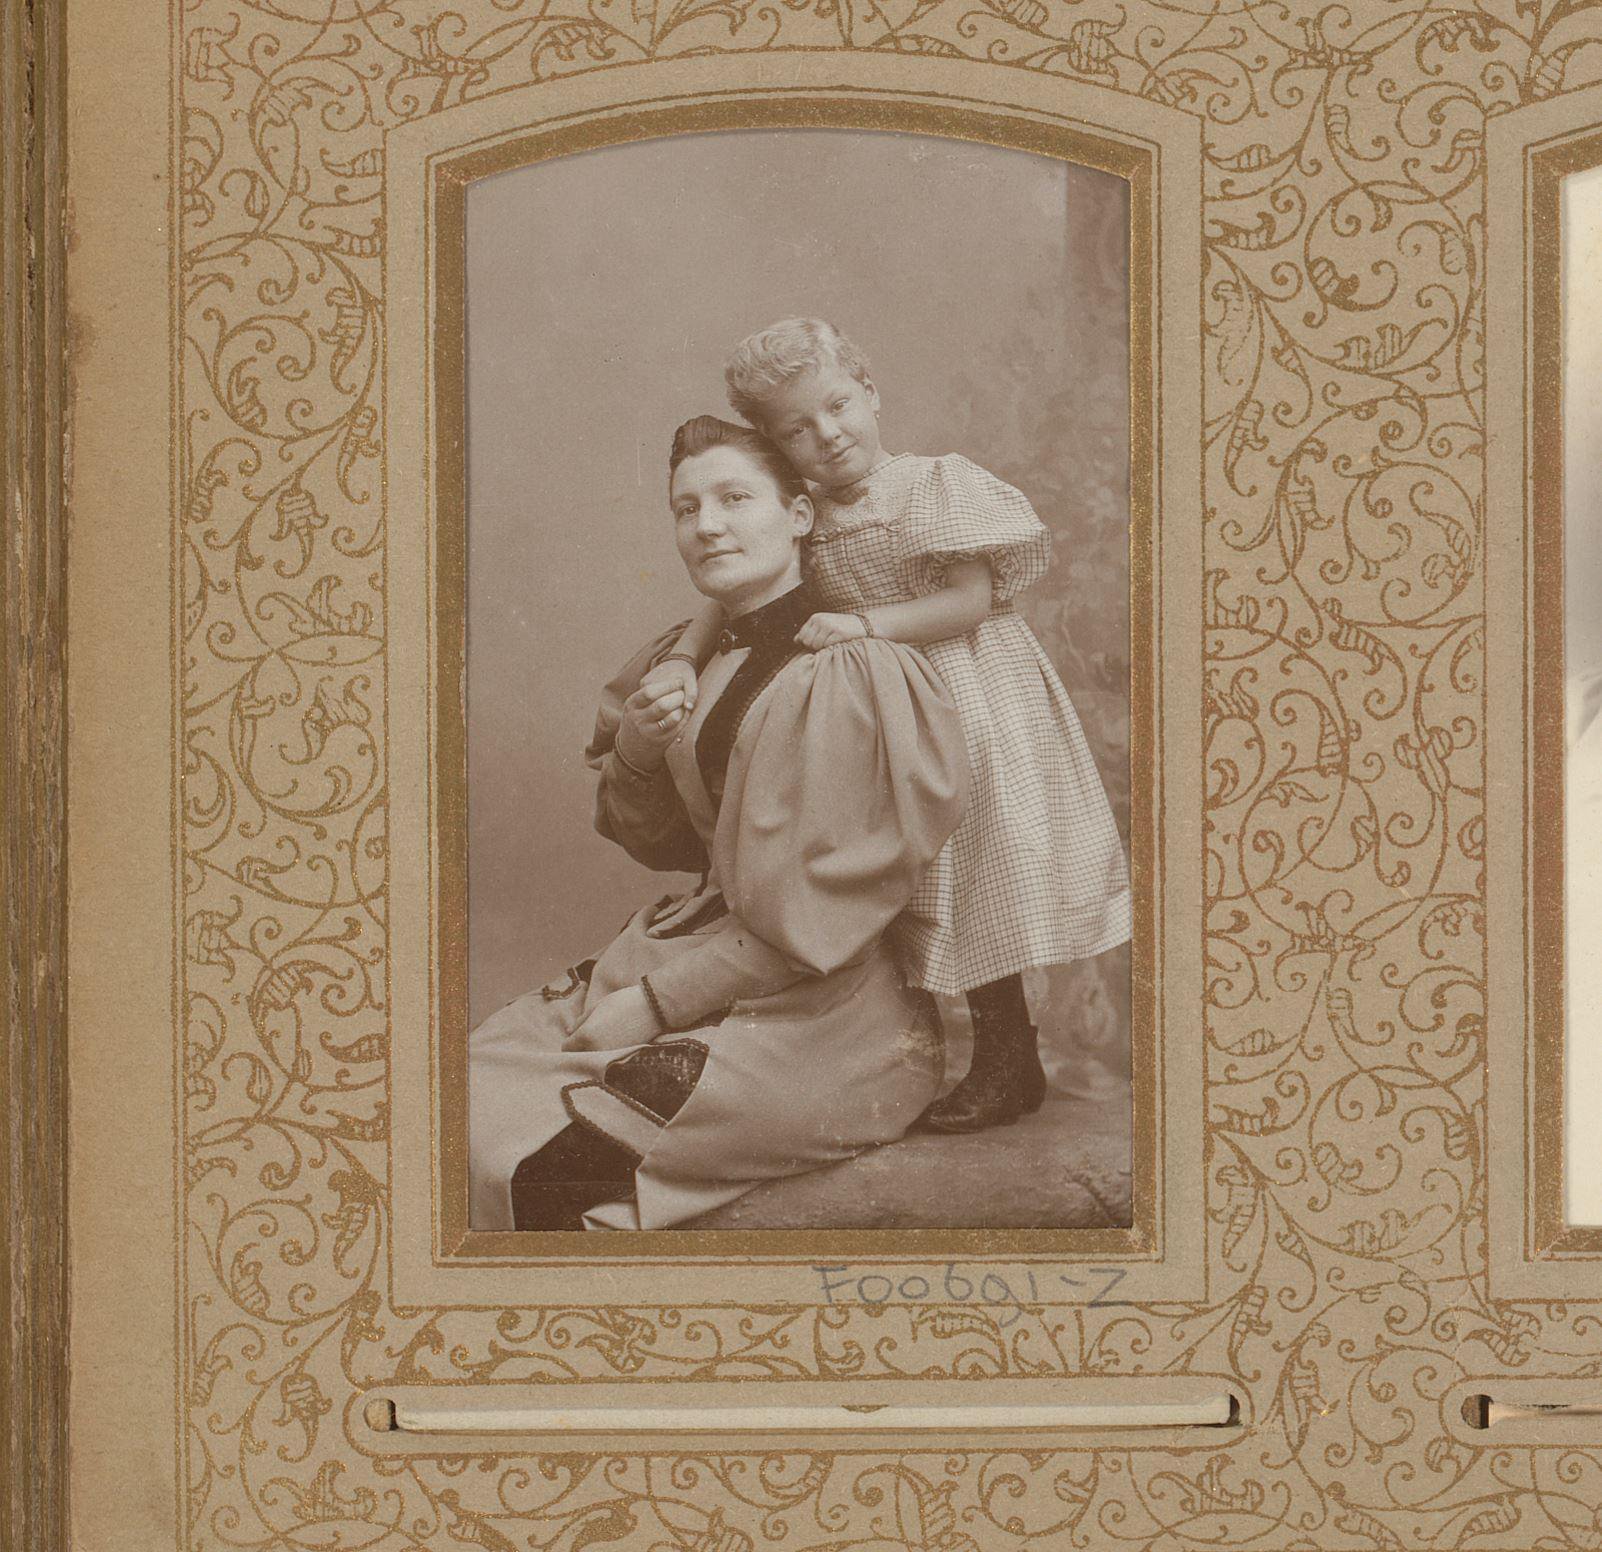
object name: carte de visite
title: Portret van een vrouw en meisje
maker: j.w. wentzel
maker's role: fotograaf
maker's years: 1855-1930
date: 1890-1898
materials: cardboard, photographic support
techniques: collodion silver print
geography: amersfoort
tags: historical persons - bb - woman, girl (child between toddler and youth)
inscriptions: inscription: ‘J.W. Wentzel/ Amersfoort/ Langestraat F.12’